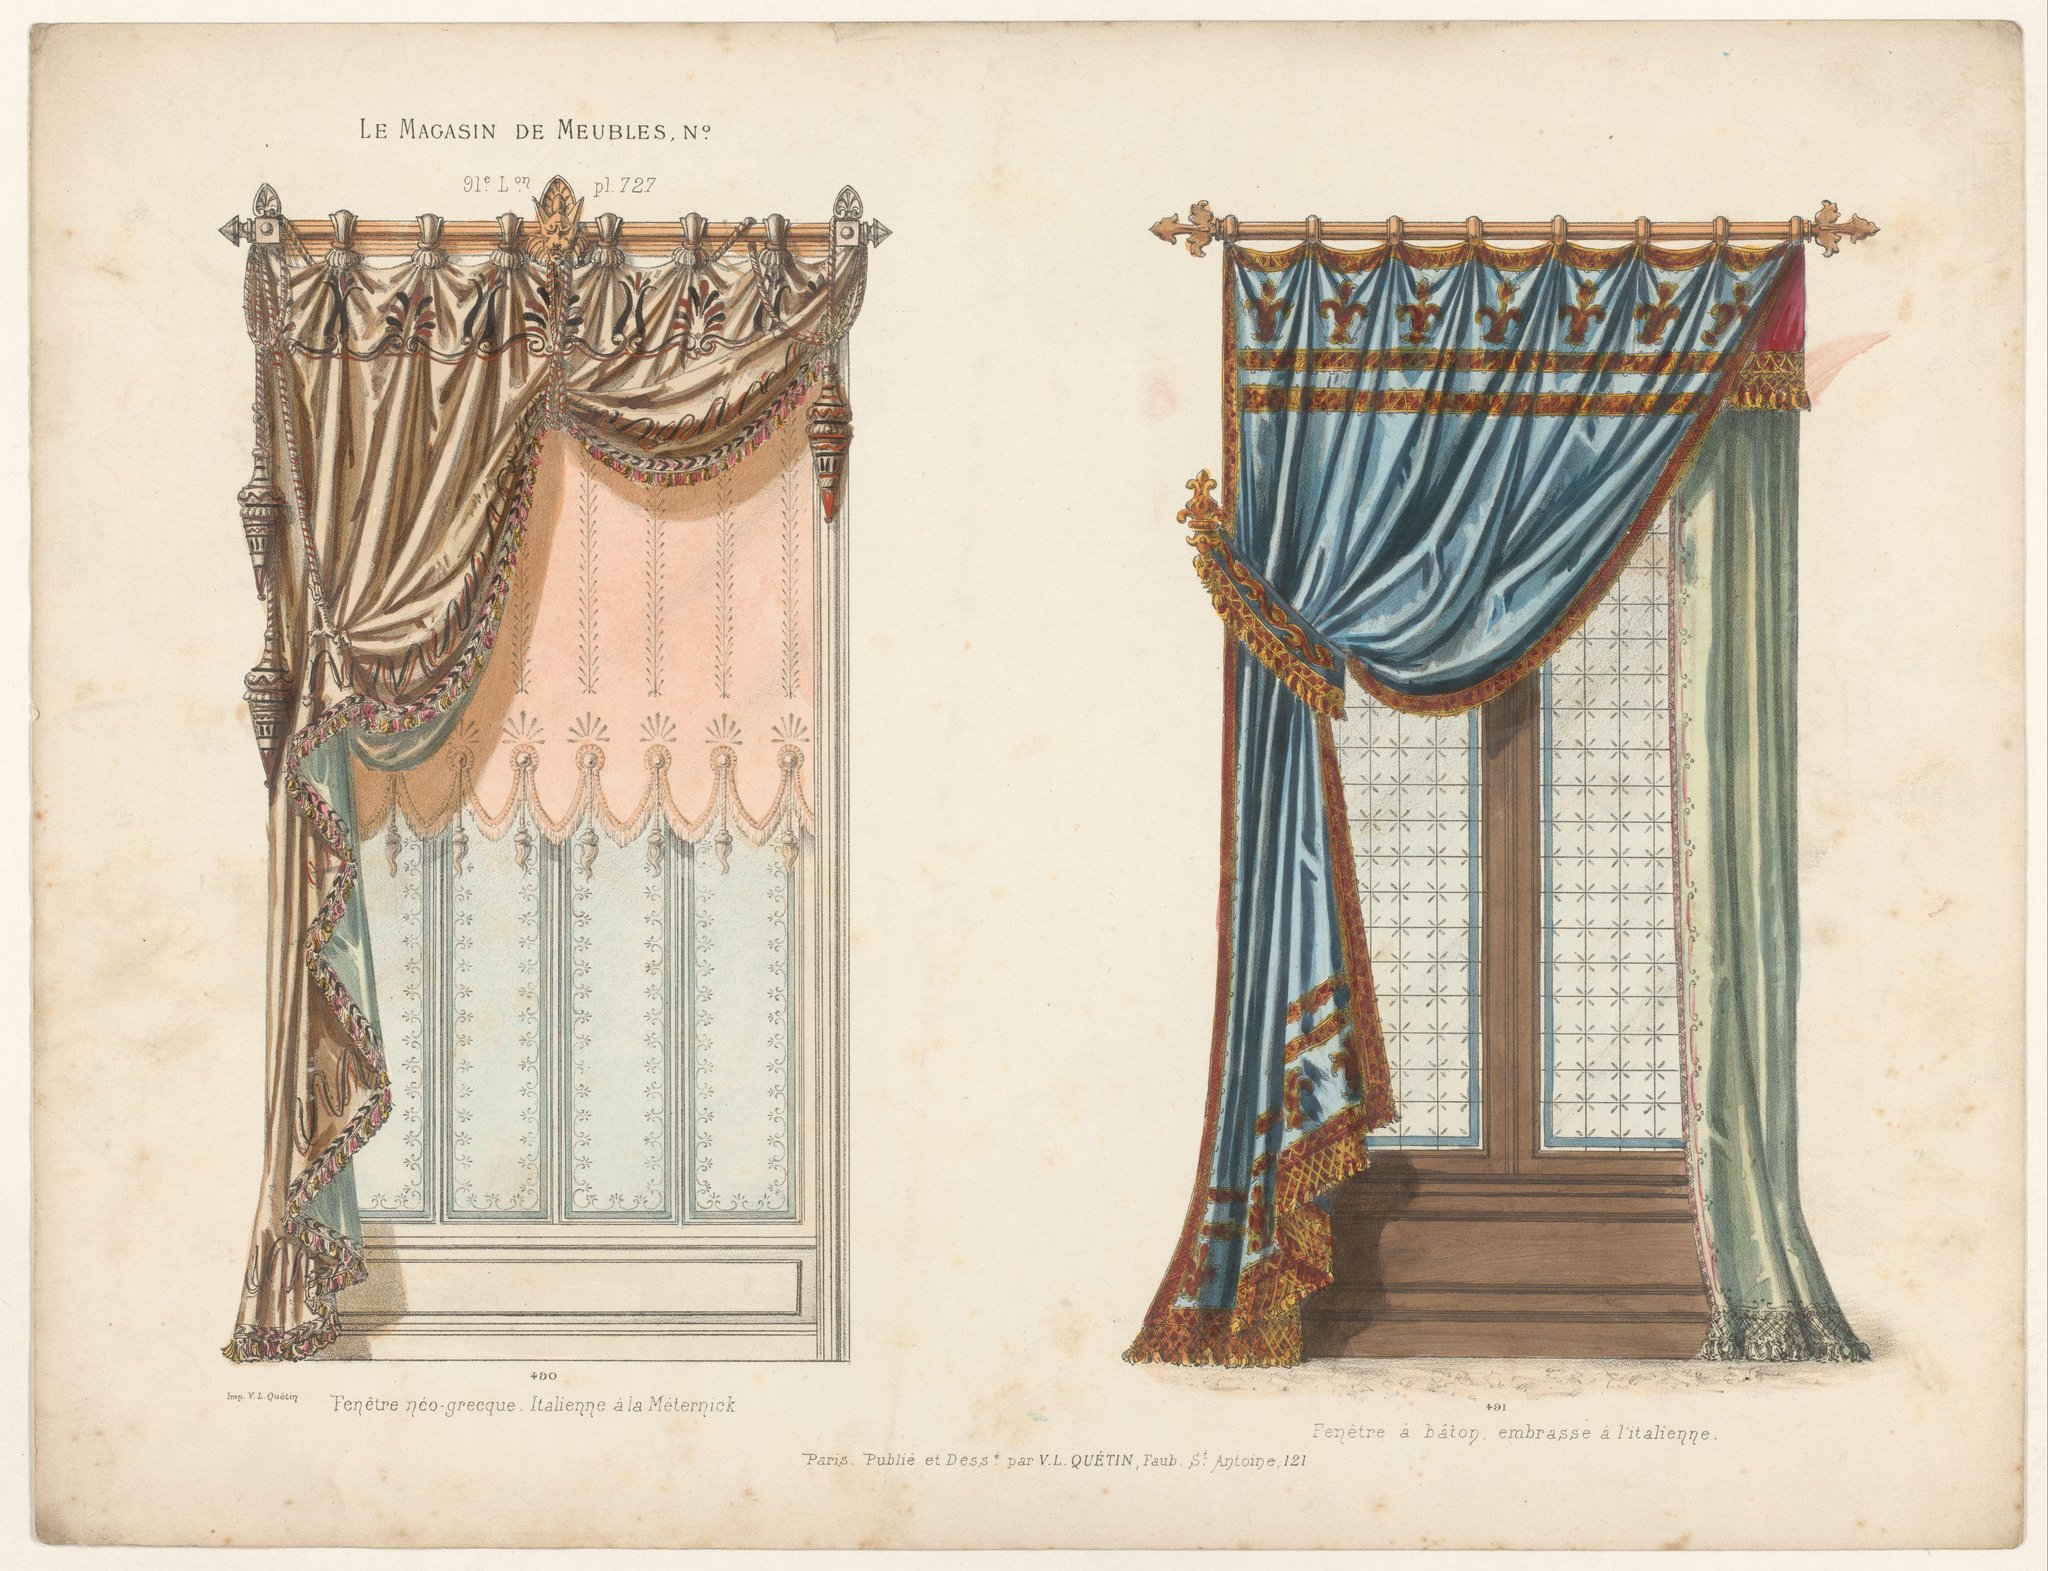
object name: print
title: Le Magasin de Meubles No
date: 1878-1904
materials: paper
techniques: hand coloring, lithograph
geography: paris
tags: window, hangings and drapery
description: Twee vensters met gedrapeerde gordijnen. Prent uit 91e Livraison.